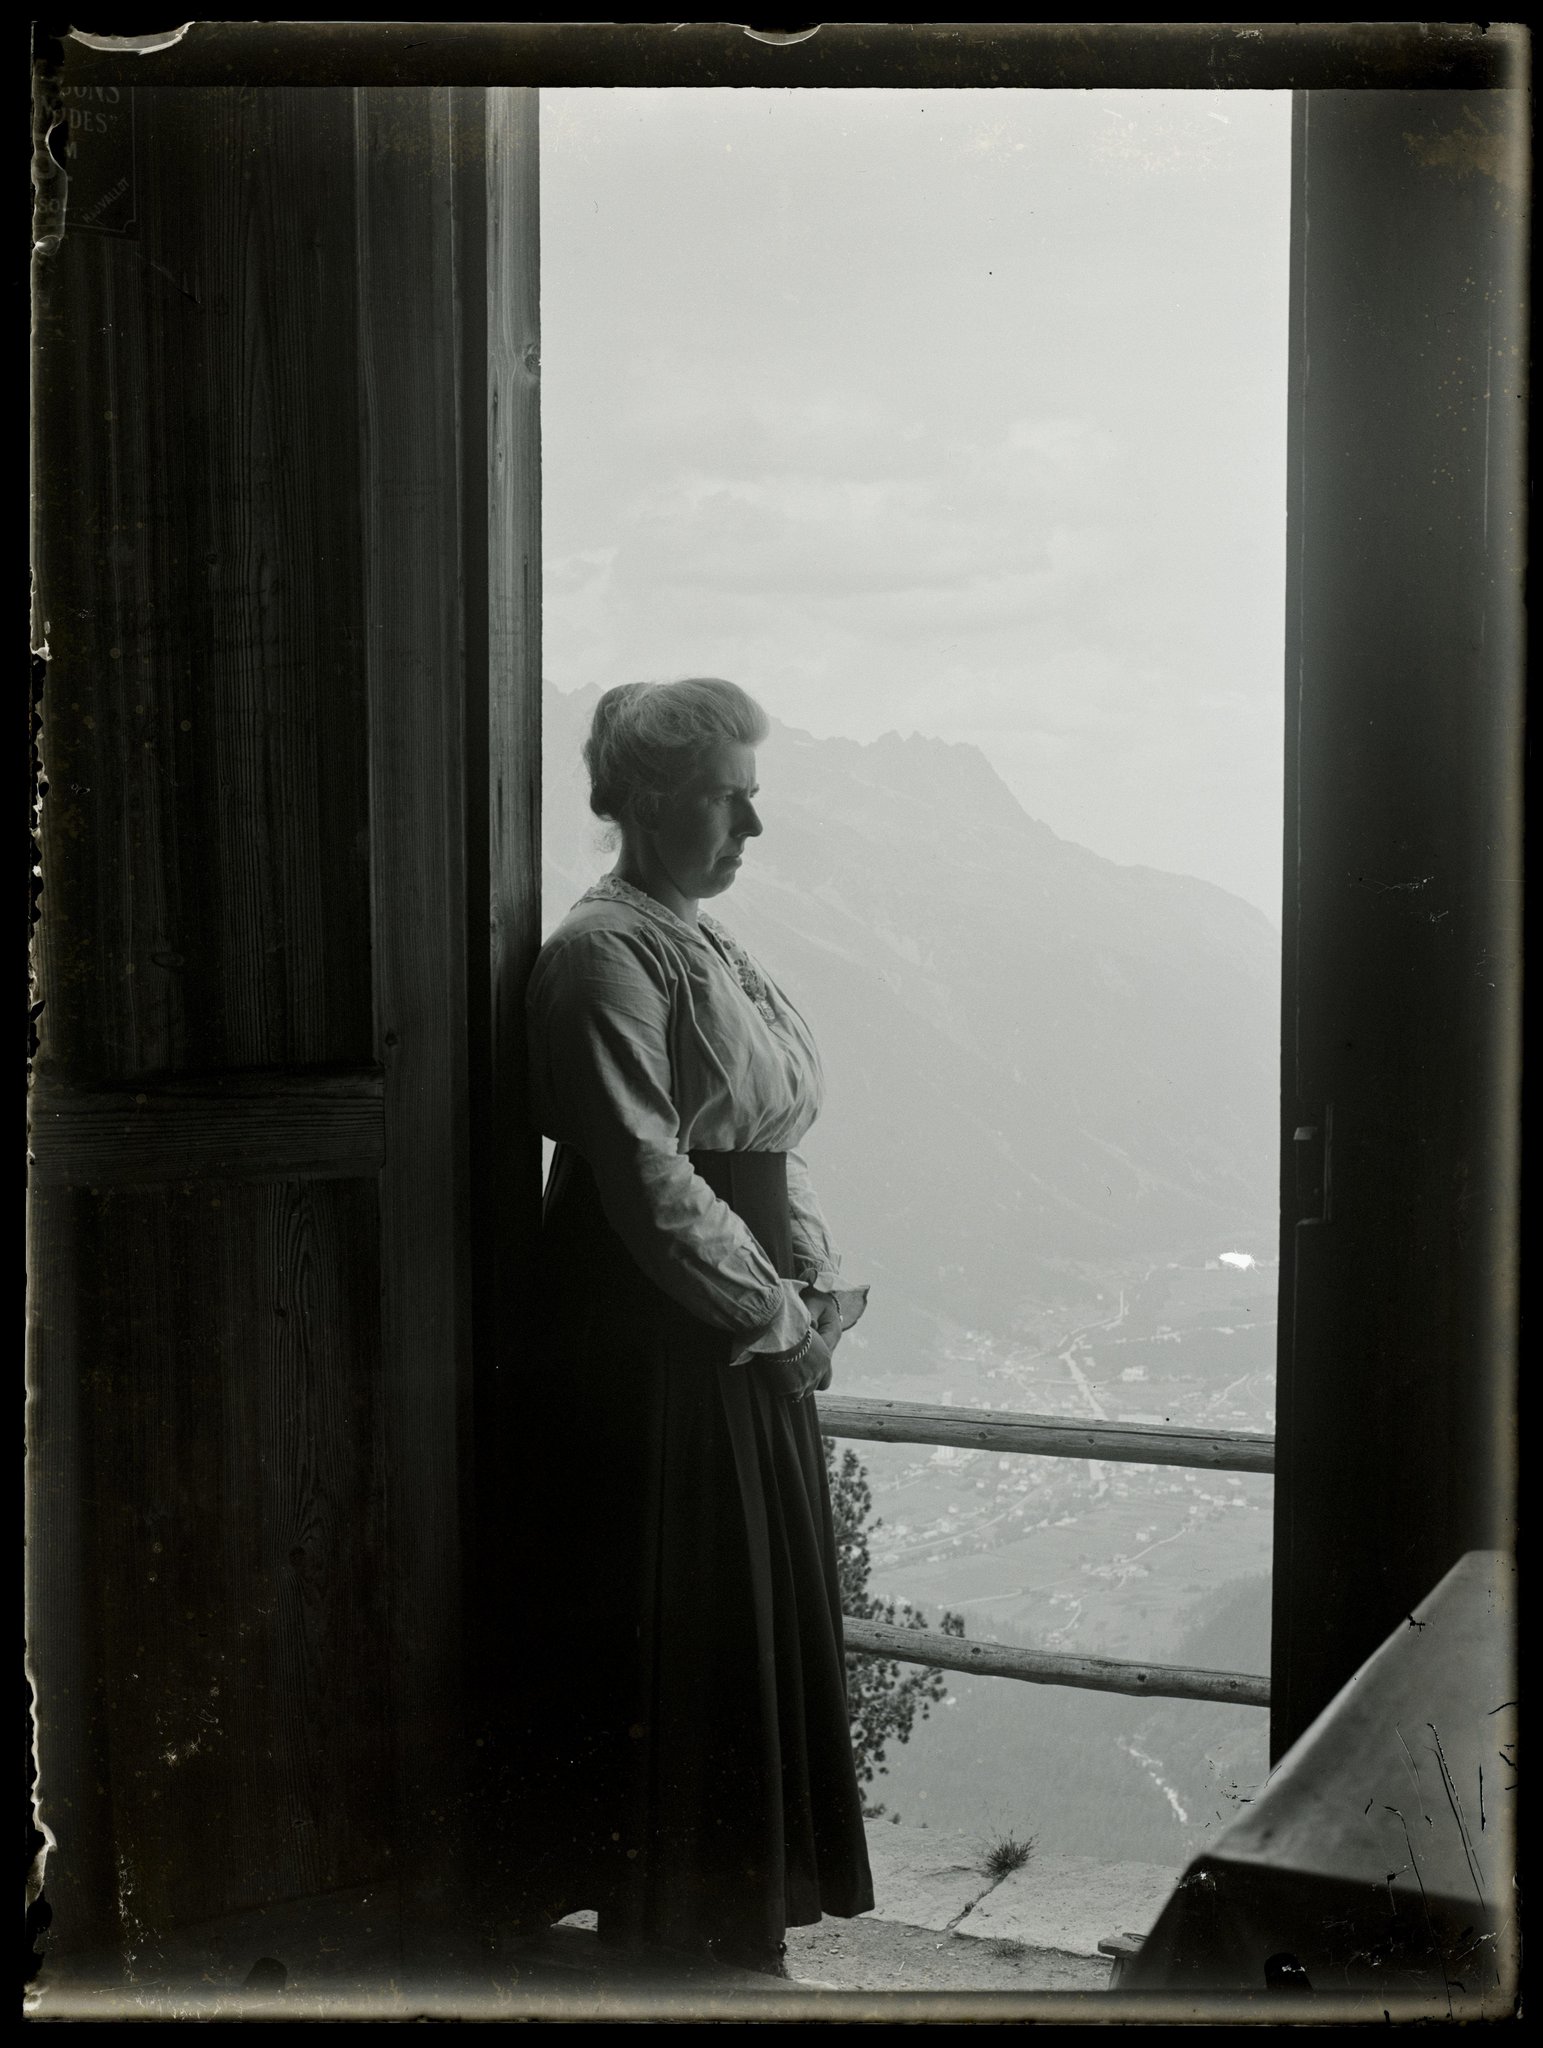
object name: glasnegatief, glasplaatnegatief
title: Portret van een onbekende vrouw bij een balkon met uitzicht op bergen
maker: Anonymous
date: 1907-1935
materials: glass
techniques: gelatin glass negative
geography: europe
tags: historical persons not known by name - bb - woman, balcony, mountains, europe